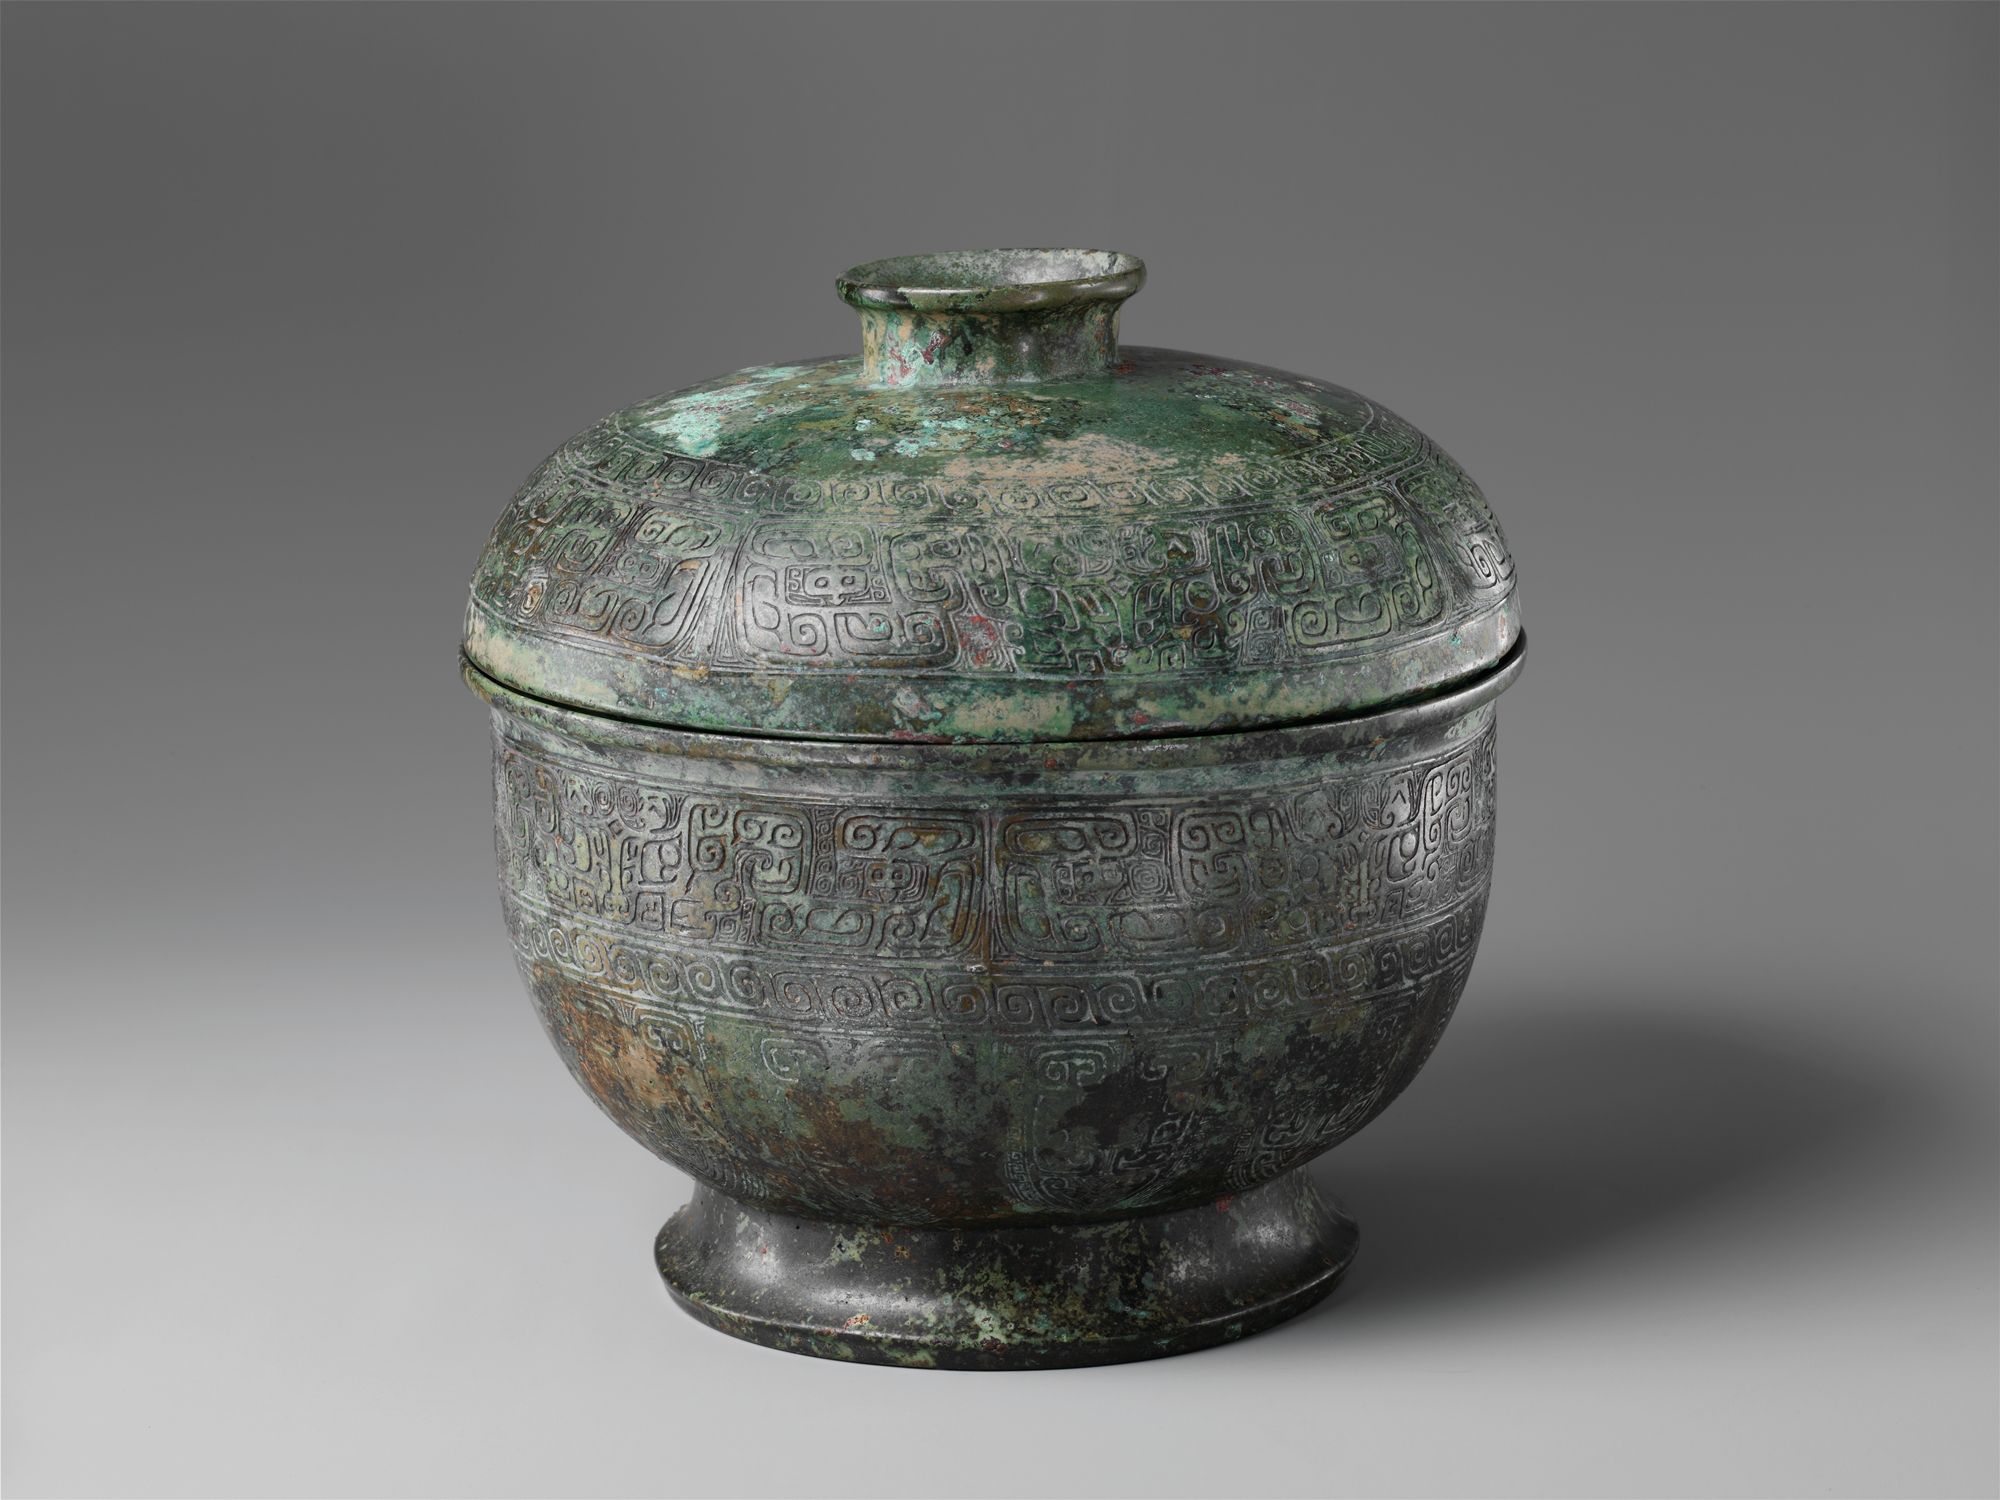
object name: vessel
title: Food serving vessel (Yu)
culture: chinese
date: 500-401 BCE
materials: bronze